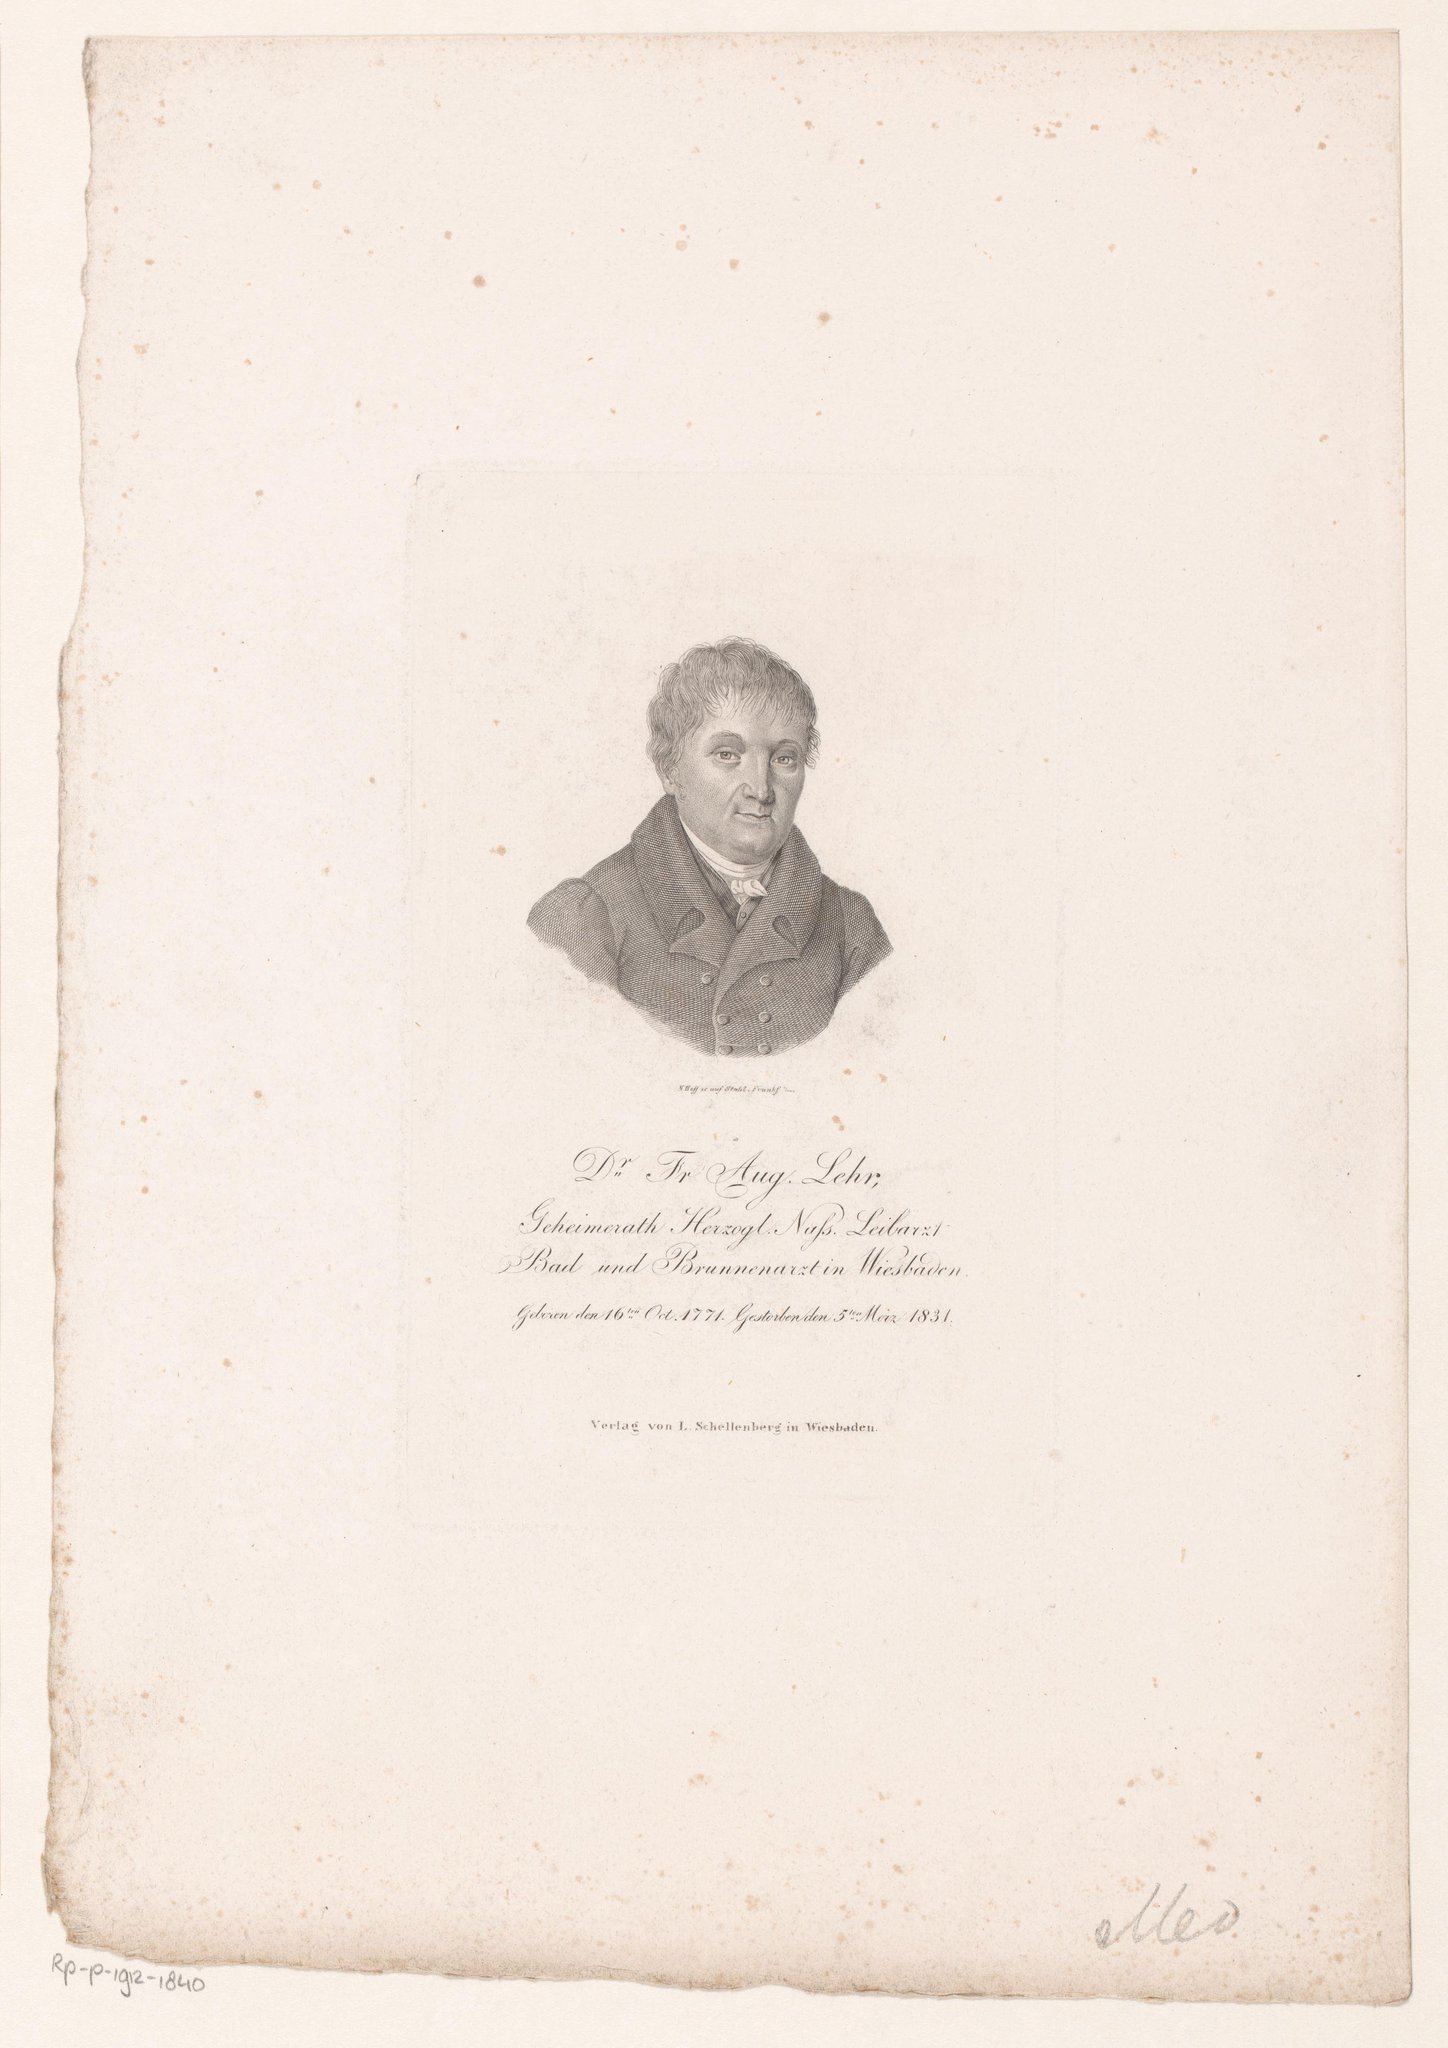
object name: print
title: Portret van Friedrich August Lehr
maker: nikolaus hoff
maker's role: print maker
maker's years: 1798-1873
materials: paper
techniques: engraving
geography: frankfurt am main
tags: historical persons, physician, doctor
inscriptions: collector's mark: Lugt 2228